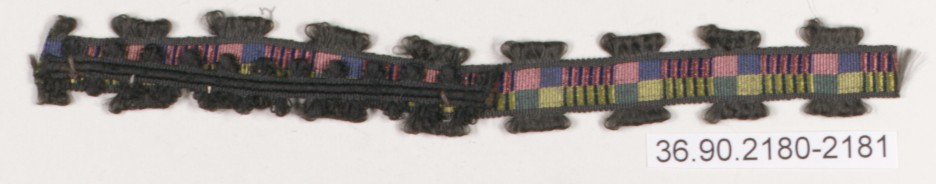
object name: piece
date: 1801-1900